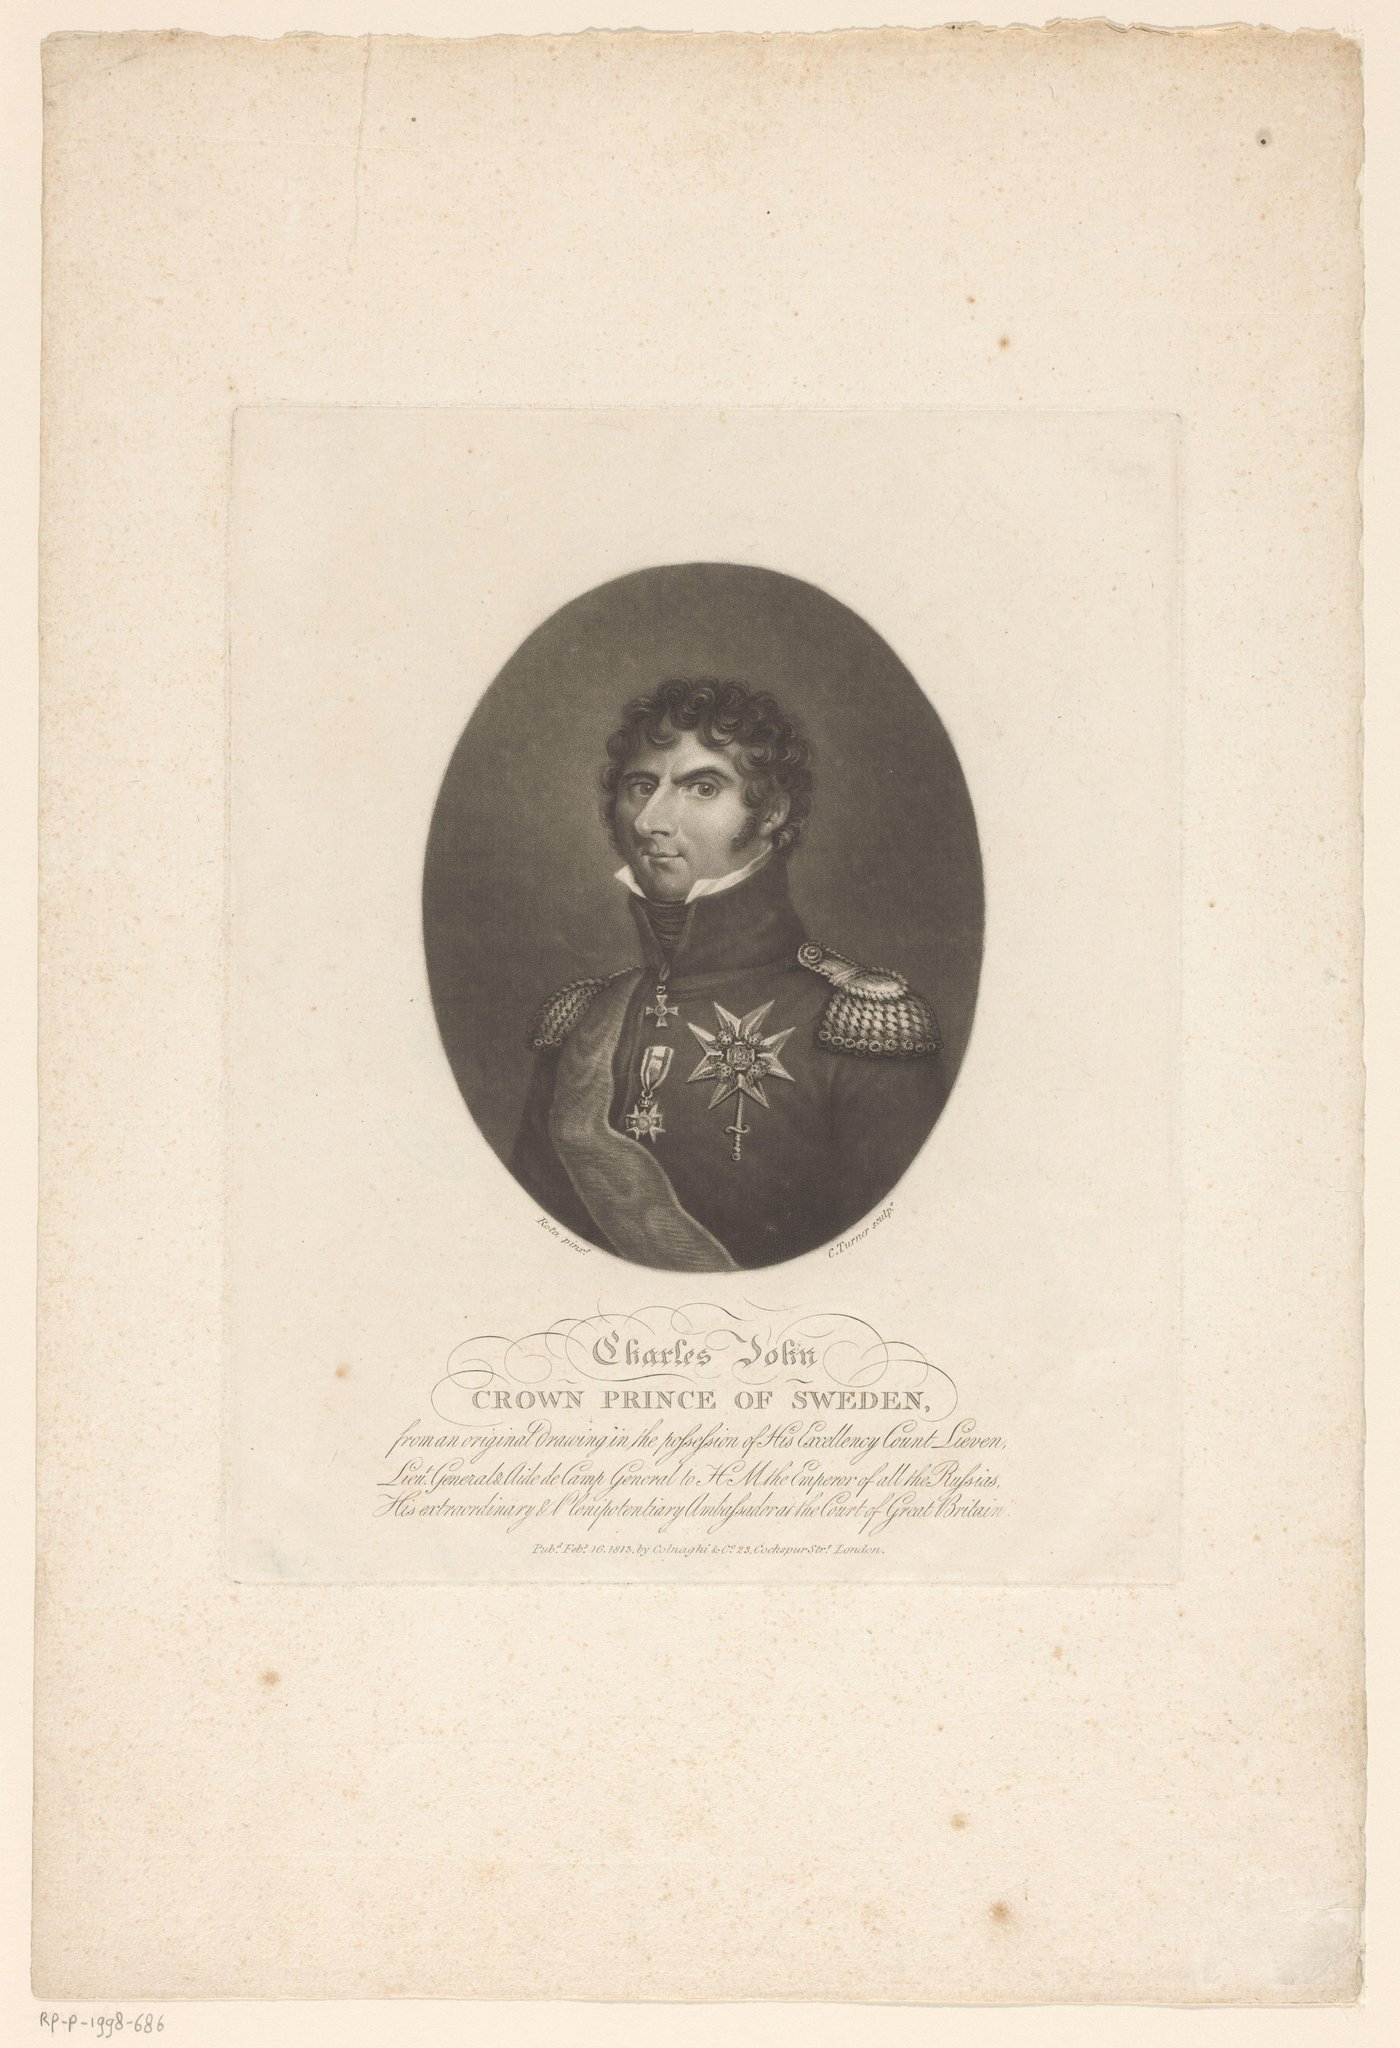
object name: print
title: Portret van Karel XIV Johan van Zweden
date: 1802-1813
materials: paper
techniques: mezzotint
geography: london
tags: historical persons, crown prince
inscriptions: collector's mark: Lugt 2228